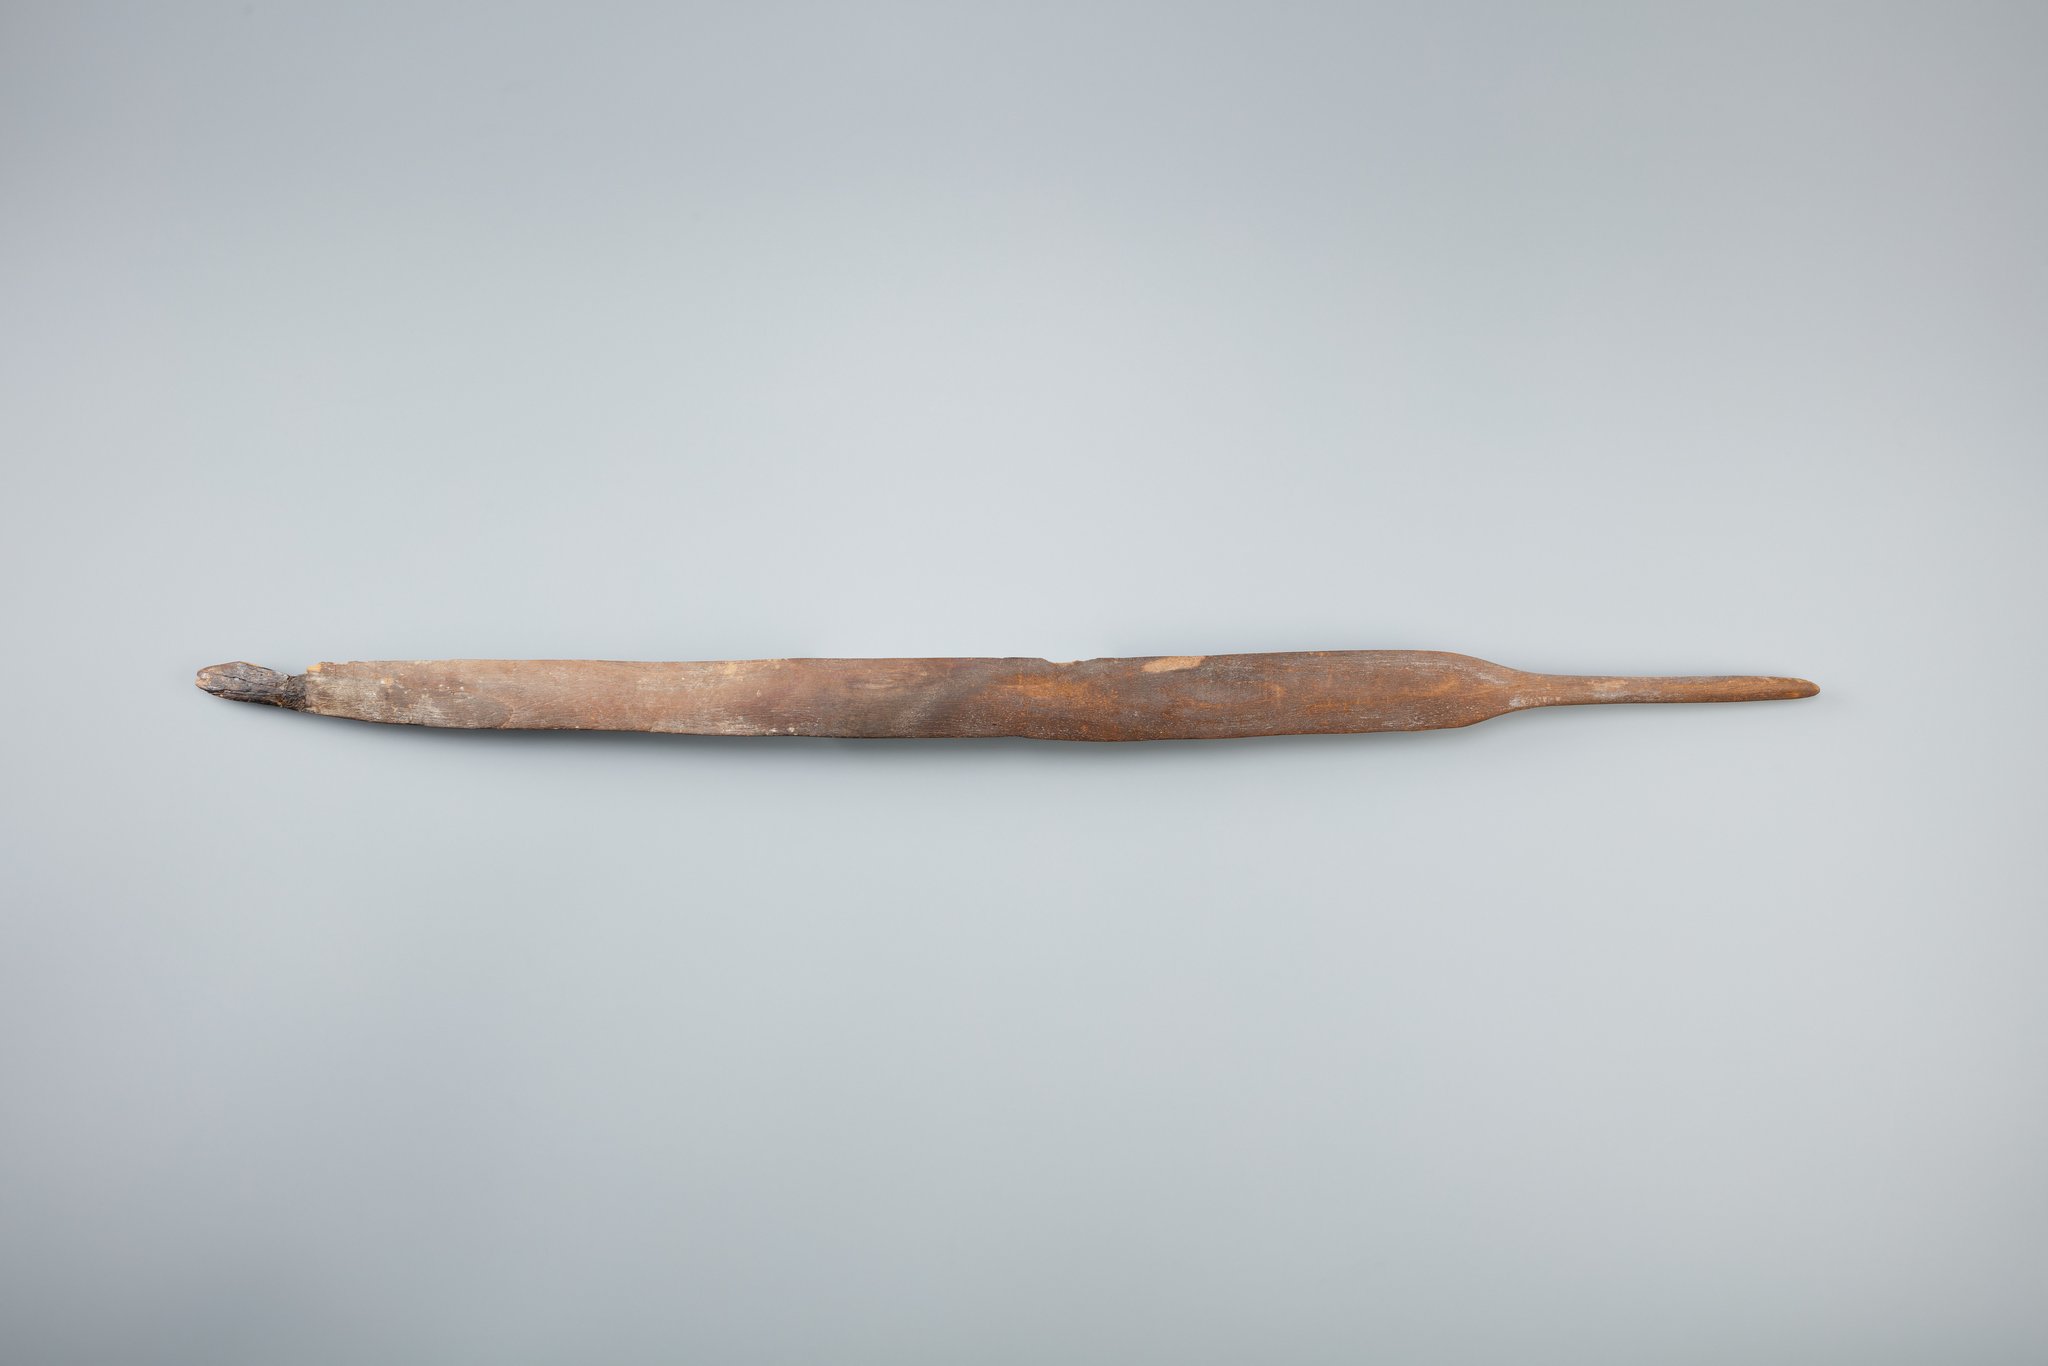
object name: weaving shuttle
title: Weaver's Shuttle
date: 1295-1070 BCE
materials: wood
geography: egypt